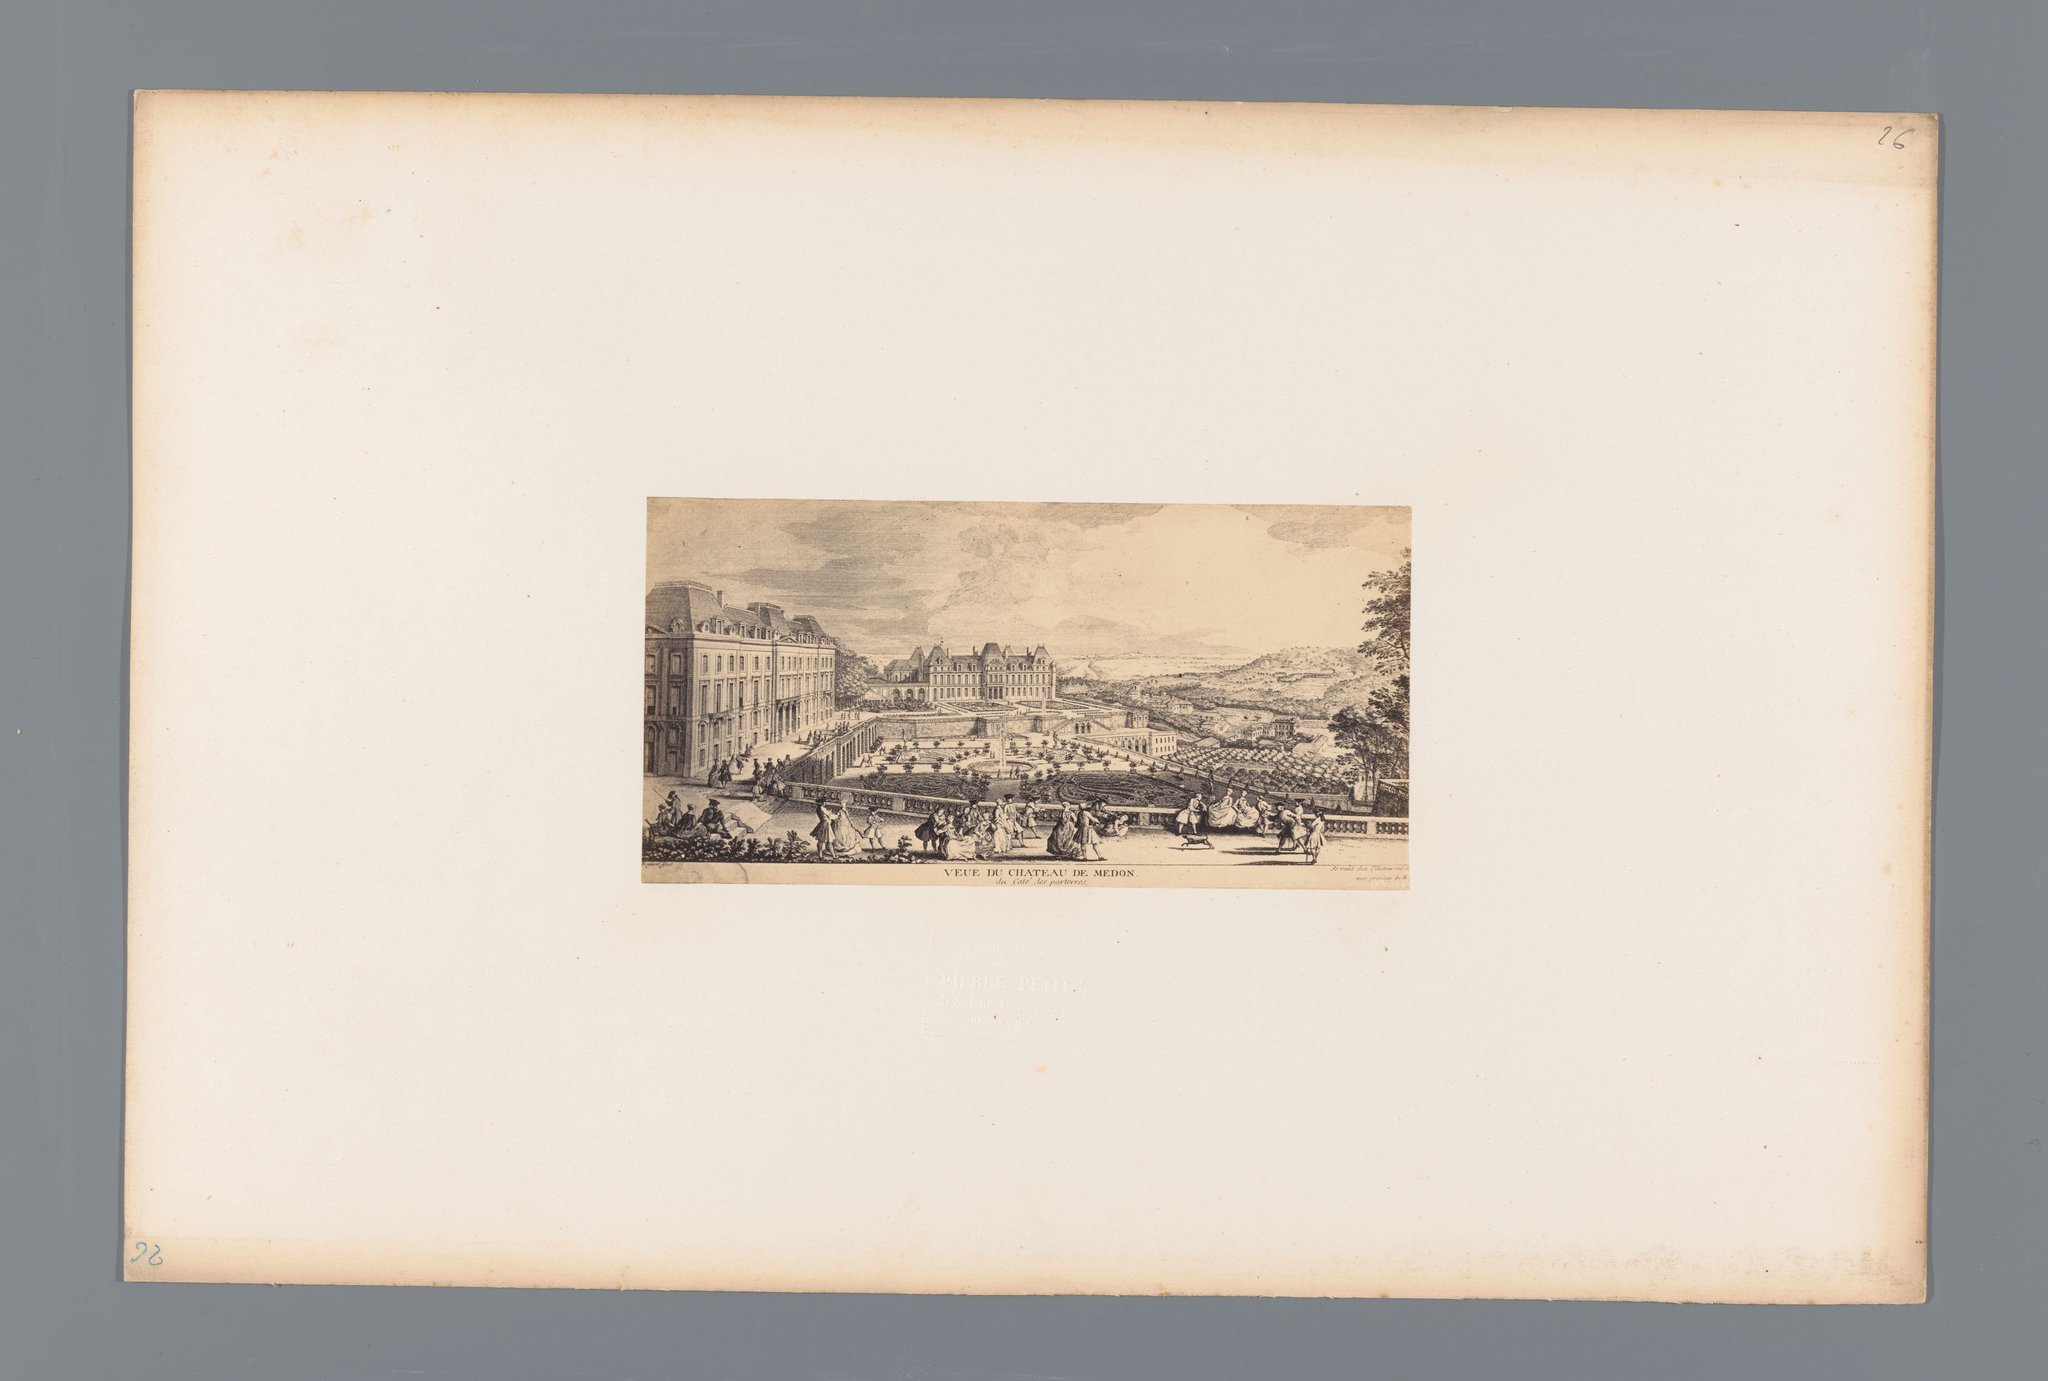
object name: photograph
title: Fotoreproductie van een ontwerp van een gezicht op het kasteel van Meudon, gezien vanaf de kant met de bloemperken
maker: pierre petit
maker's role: fotograaf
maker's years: 1832-1909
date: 1860-1865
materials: photographic support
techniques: albumen print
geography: paris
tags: castle, ornamental plants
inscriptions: number: ‘26’, check stamp: ‘PHOTOGRAPHIE des DEUX MONDES/ PIERRE PETIT/ 31, Rue Cadet, 31/ PARIS’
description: Deze foto maakt deel uit van een omslag met 38 foto's en 17 tekstbladen.